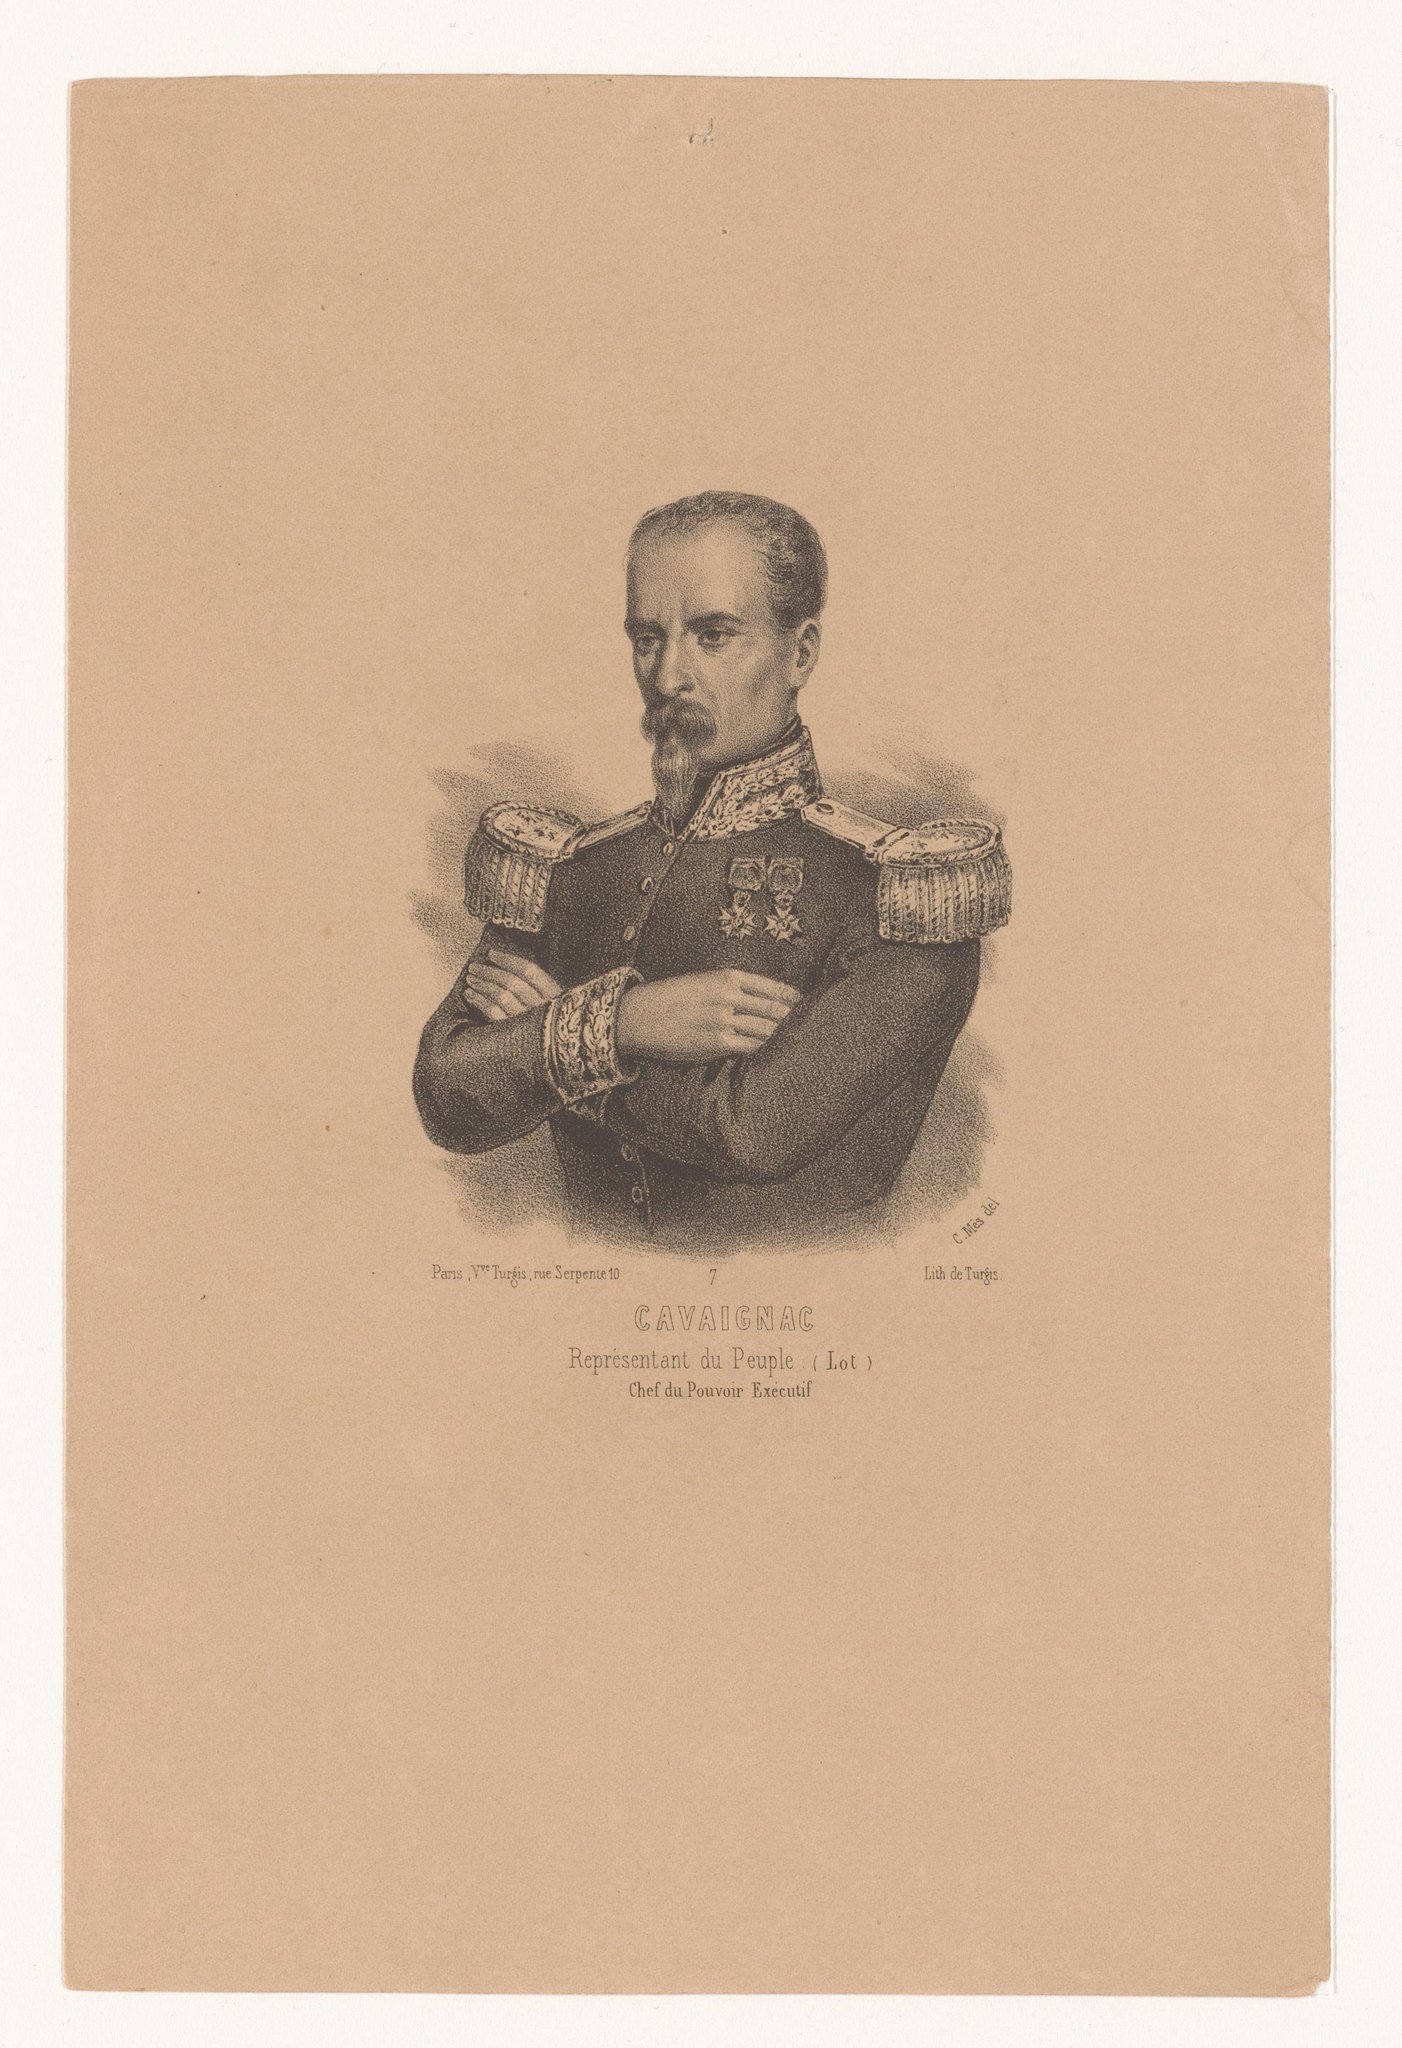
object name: print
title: Portret van Louis-Eugène Cavaignac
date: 1848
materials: paper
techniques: lithograph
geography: paris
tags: commander-in-chief, general, marshal, historical persons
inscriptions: collector's mark: Lugt 2228